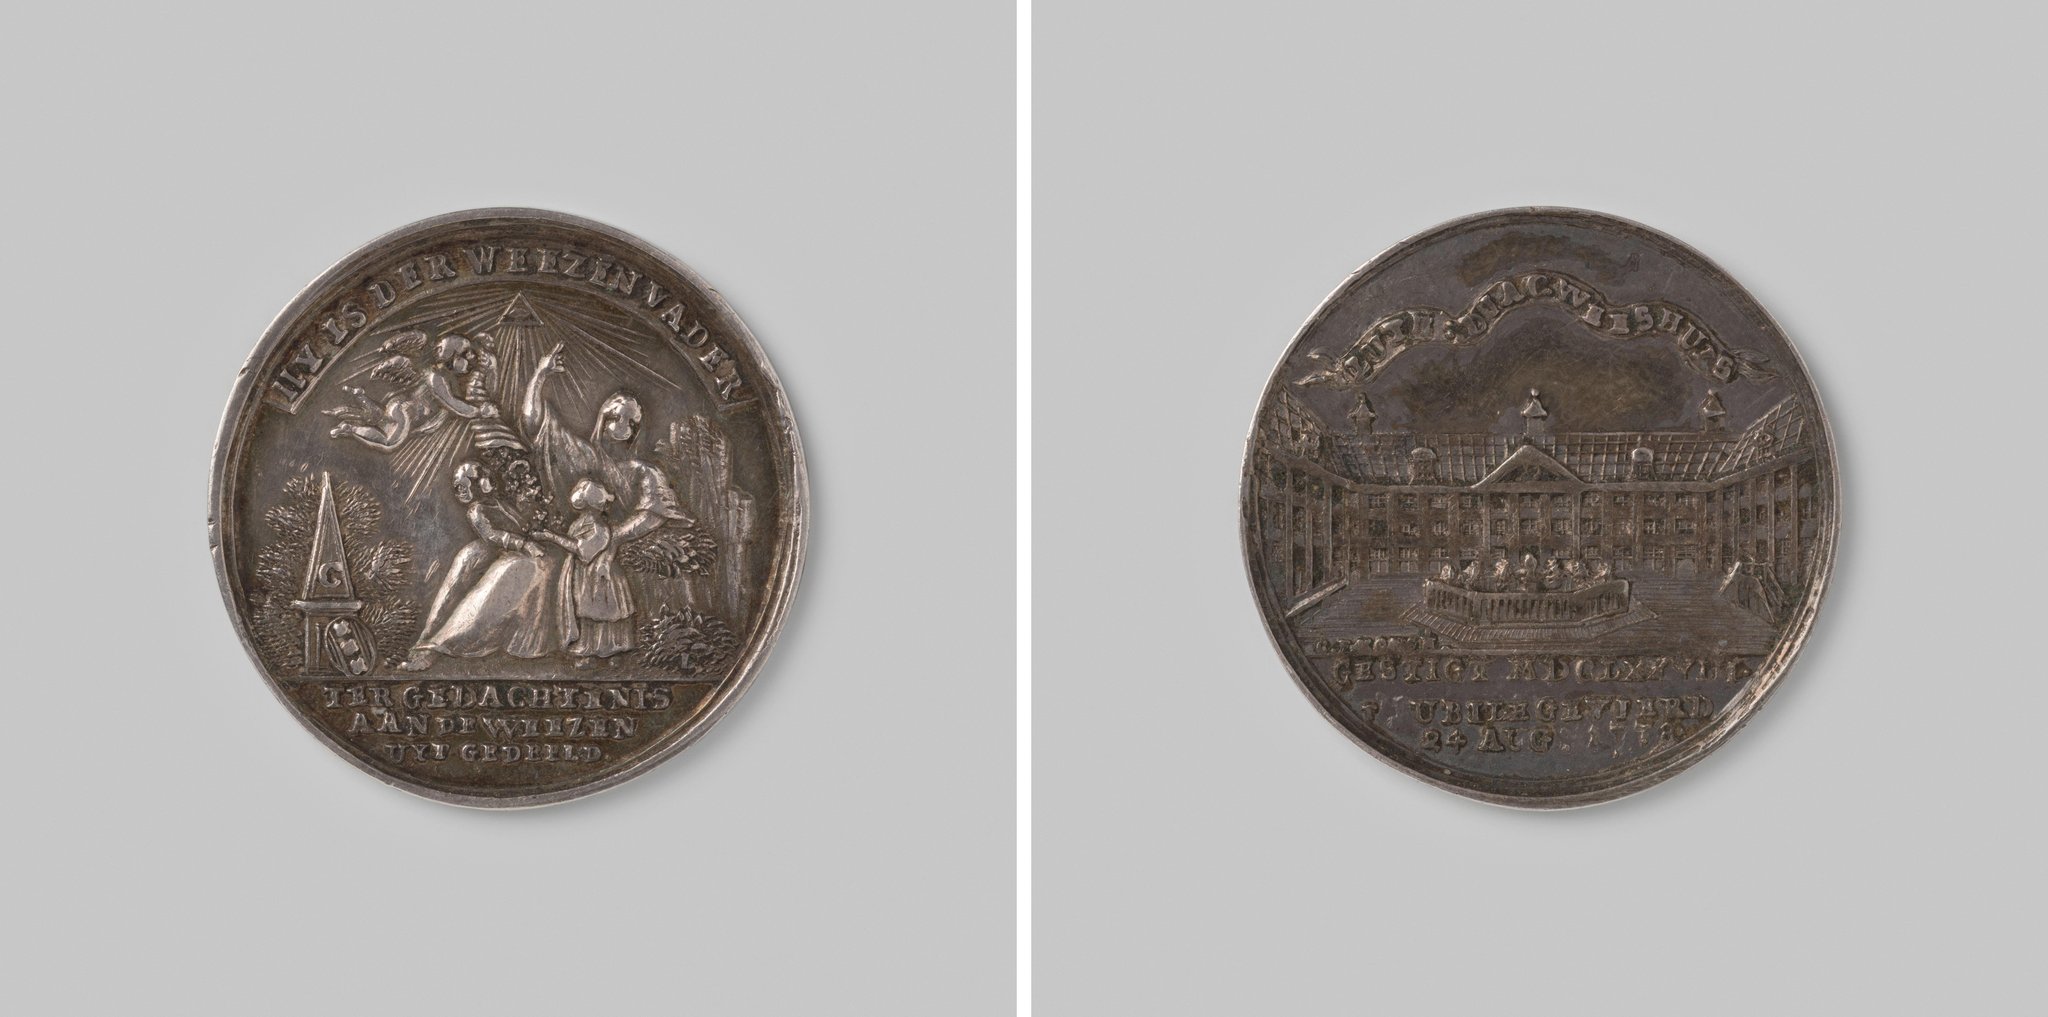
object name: history medal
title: Eeuwfeest van het Luthersche Diaconie Weeshuis te Amsterdam 1778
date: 1778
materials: silver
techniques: pressing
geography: amsterdam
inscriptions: signature: ‘C.F. KONSÉ’, circumscription: ‘HY IS DER WEEZEN VADER’, exergue: ‘GESTIGT MDCLXXVIII. T' JUBILE GEVIERD 24 AVG. 1778.’, exergue: ‘TER GEDACHTENIS AAN DE WEEZEN UYTGEDEELD.’, : ‘C’, inscription: ‘LUTH. DIAC. WEESHUIS’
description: Zilveren penning, op de voorzijde een gesluierde vrouw, omhoog wijzend naar Gods stralend oog, zittend tussen twee kinderen die door een engel uit een hoorn des overvloeds bedeeld worden, links een zuil met letter C waartegen een ovaal Amsterdams schild, met omschrift en afsnedetekst, op de keerzijde: de binnenplaats van het weeshuis waarboven een lint met tekst, met afsnedetekst.